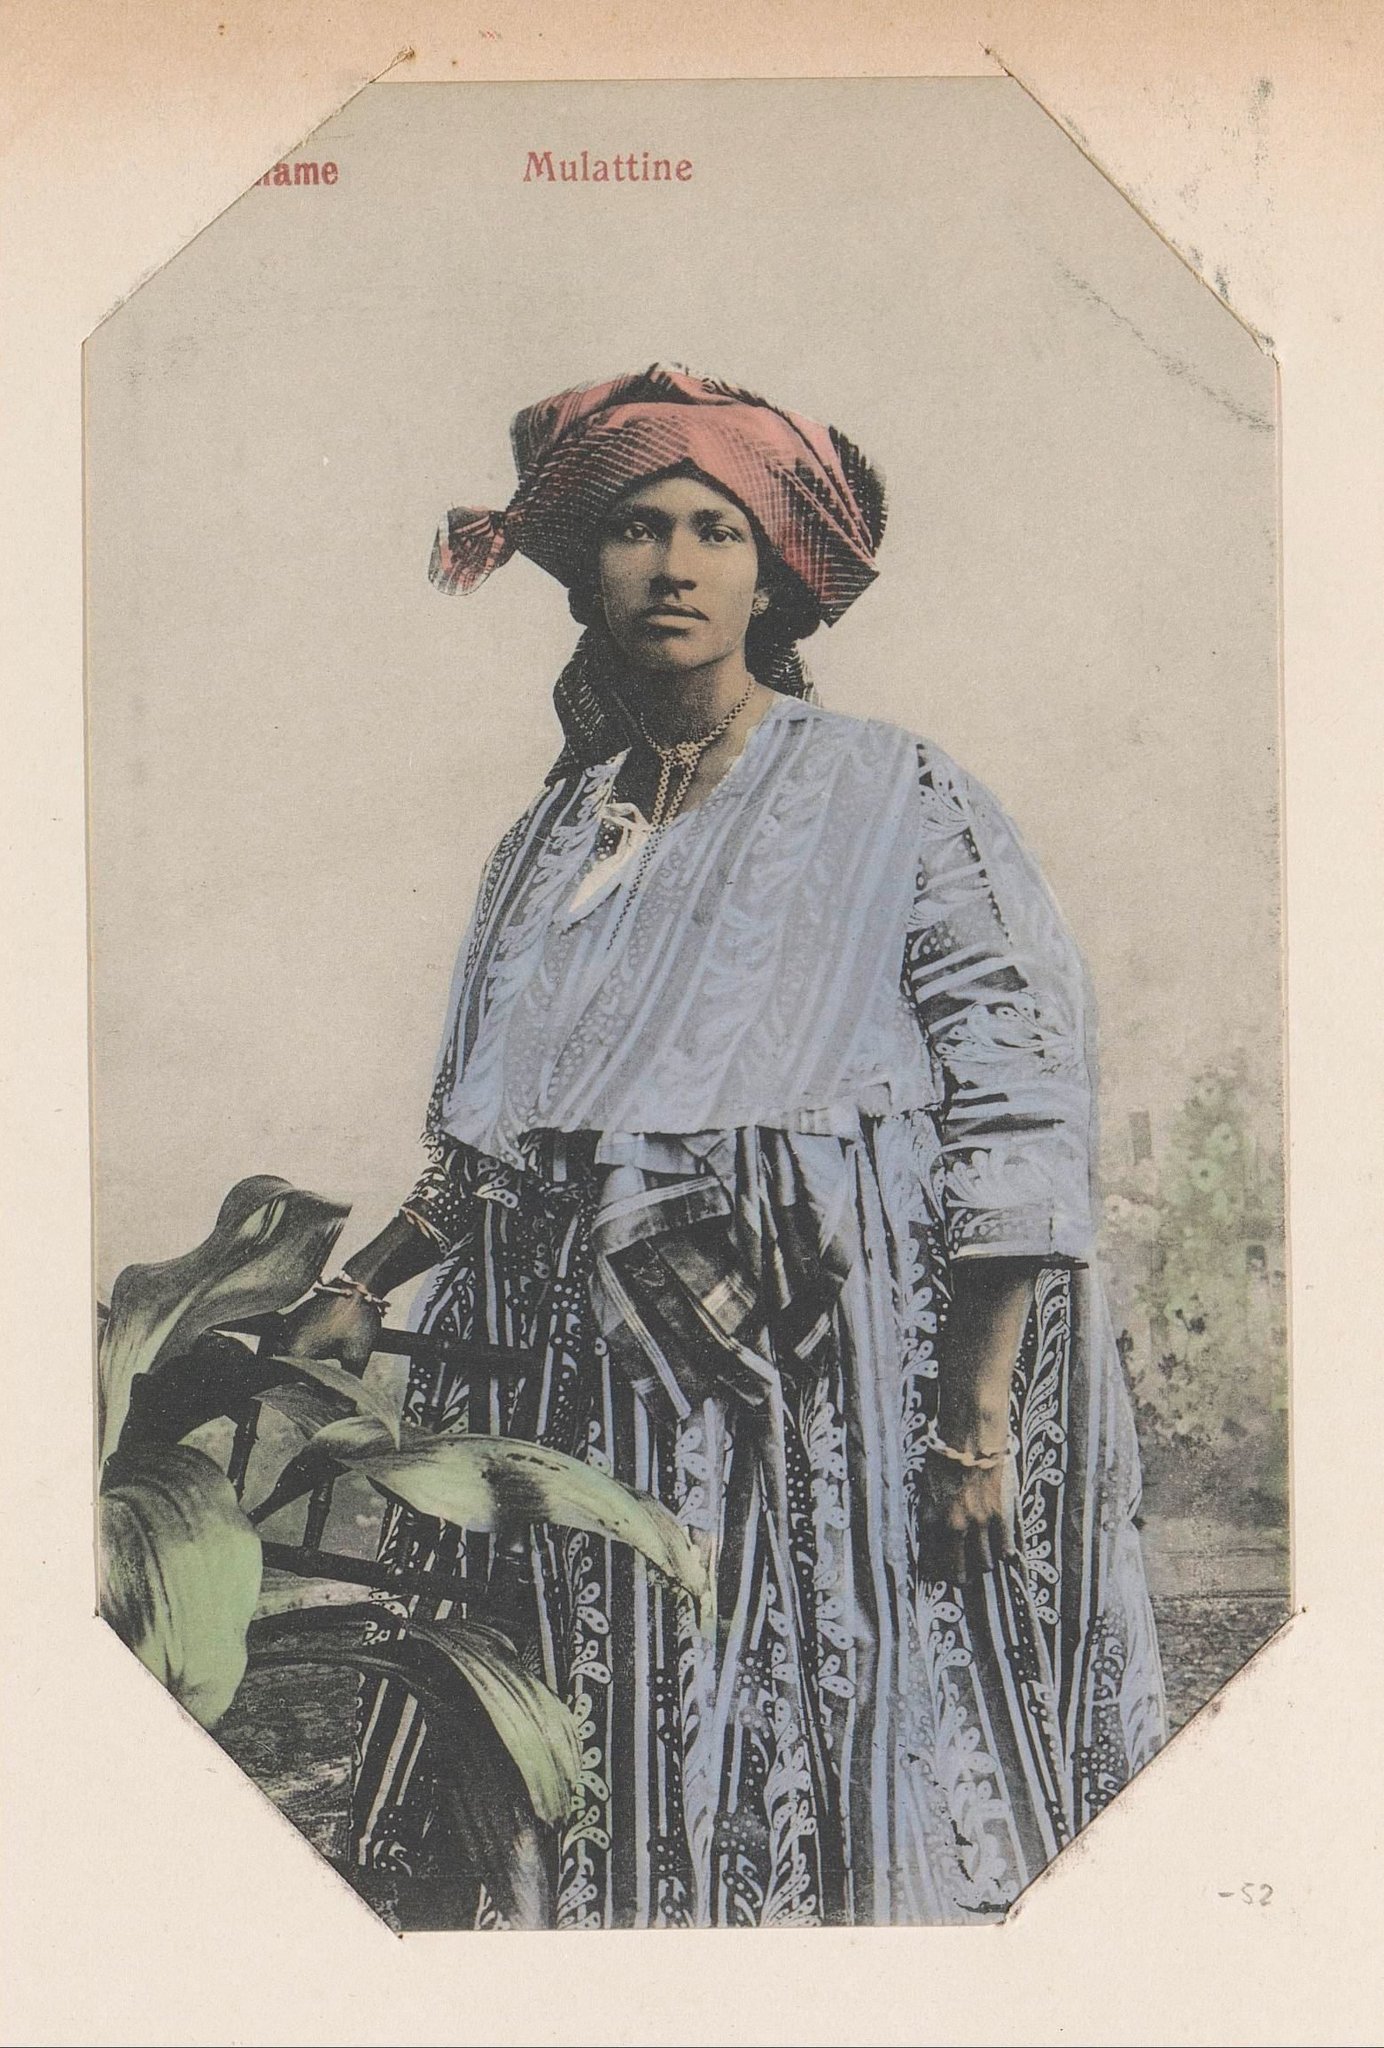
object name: ansichtkaart, prentbriefkaart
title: Mulattine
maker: eugen klein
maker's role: fotograaf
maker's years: 1869-1927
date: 1900-1910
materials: cardboard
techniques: photograph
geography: paramaribo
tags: folk costume, regional costume, standing figure - aa - female human figure, suriname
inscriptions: serial number: ‘Eigendom van Eugen Klein, Paramaribo No. 180’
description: Portret van een staande Surinaamse vrouw in koto. Onderdeel van een verzameling van 68 briefkaarten uit Suriname, bijeengebracht in een album als aandenken aan een verblijf in Suriname in september 1911.